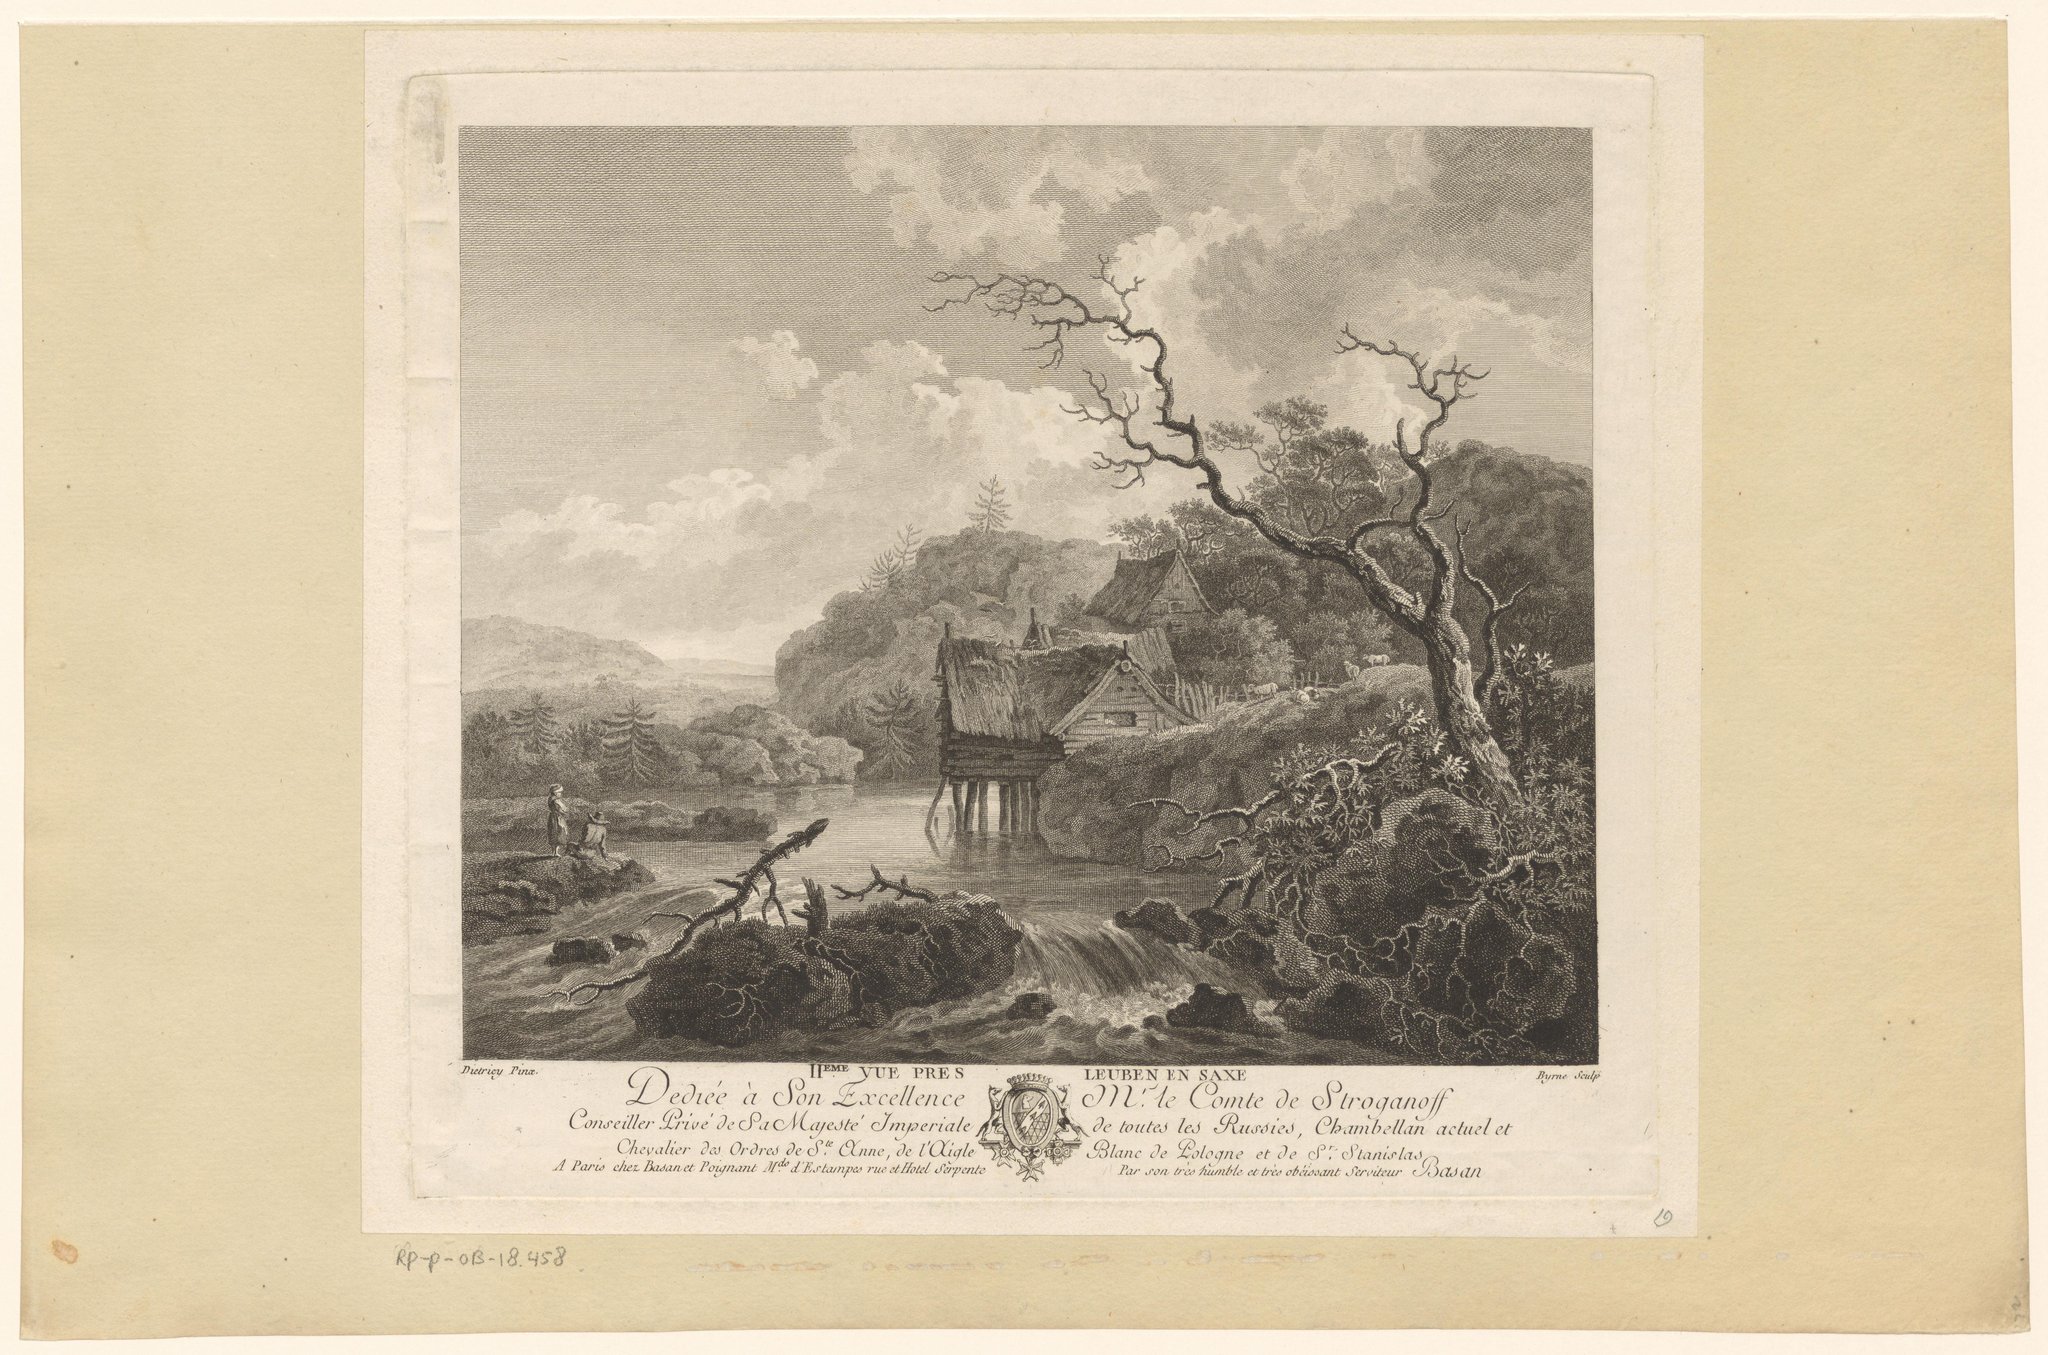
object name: print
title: Landschap met hutten naast een beek bij Leuben-Schleinitz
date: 1773-1788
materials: paper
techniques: etching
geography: london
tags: river, cottage, resting - bb - out of doors